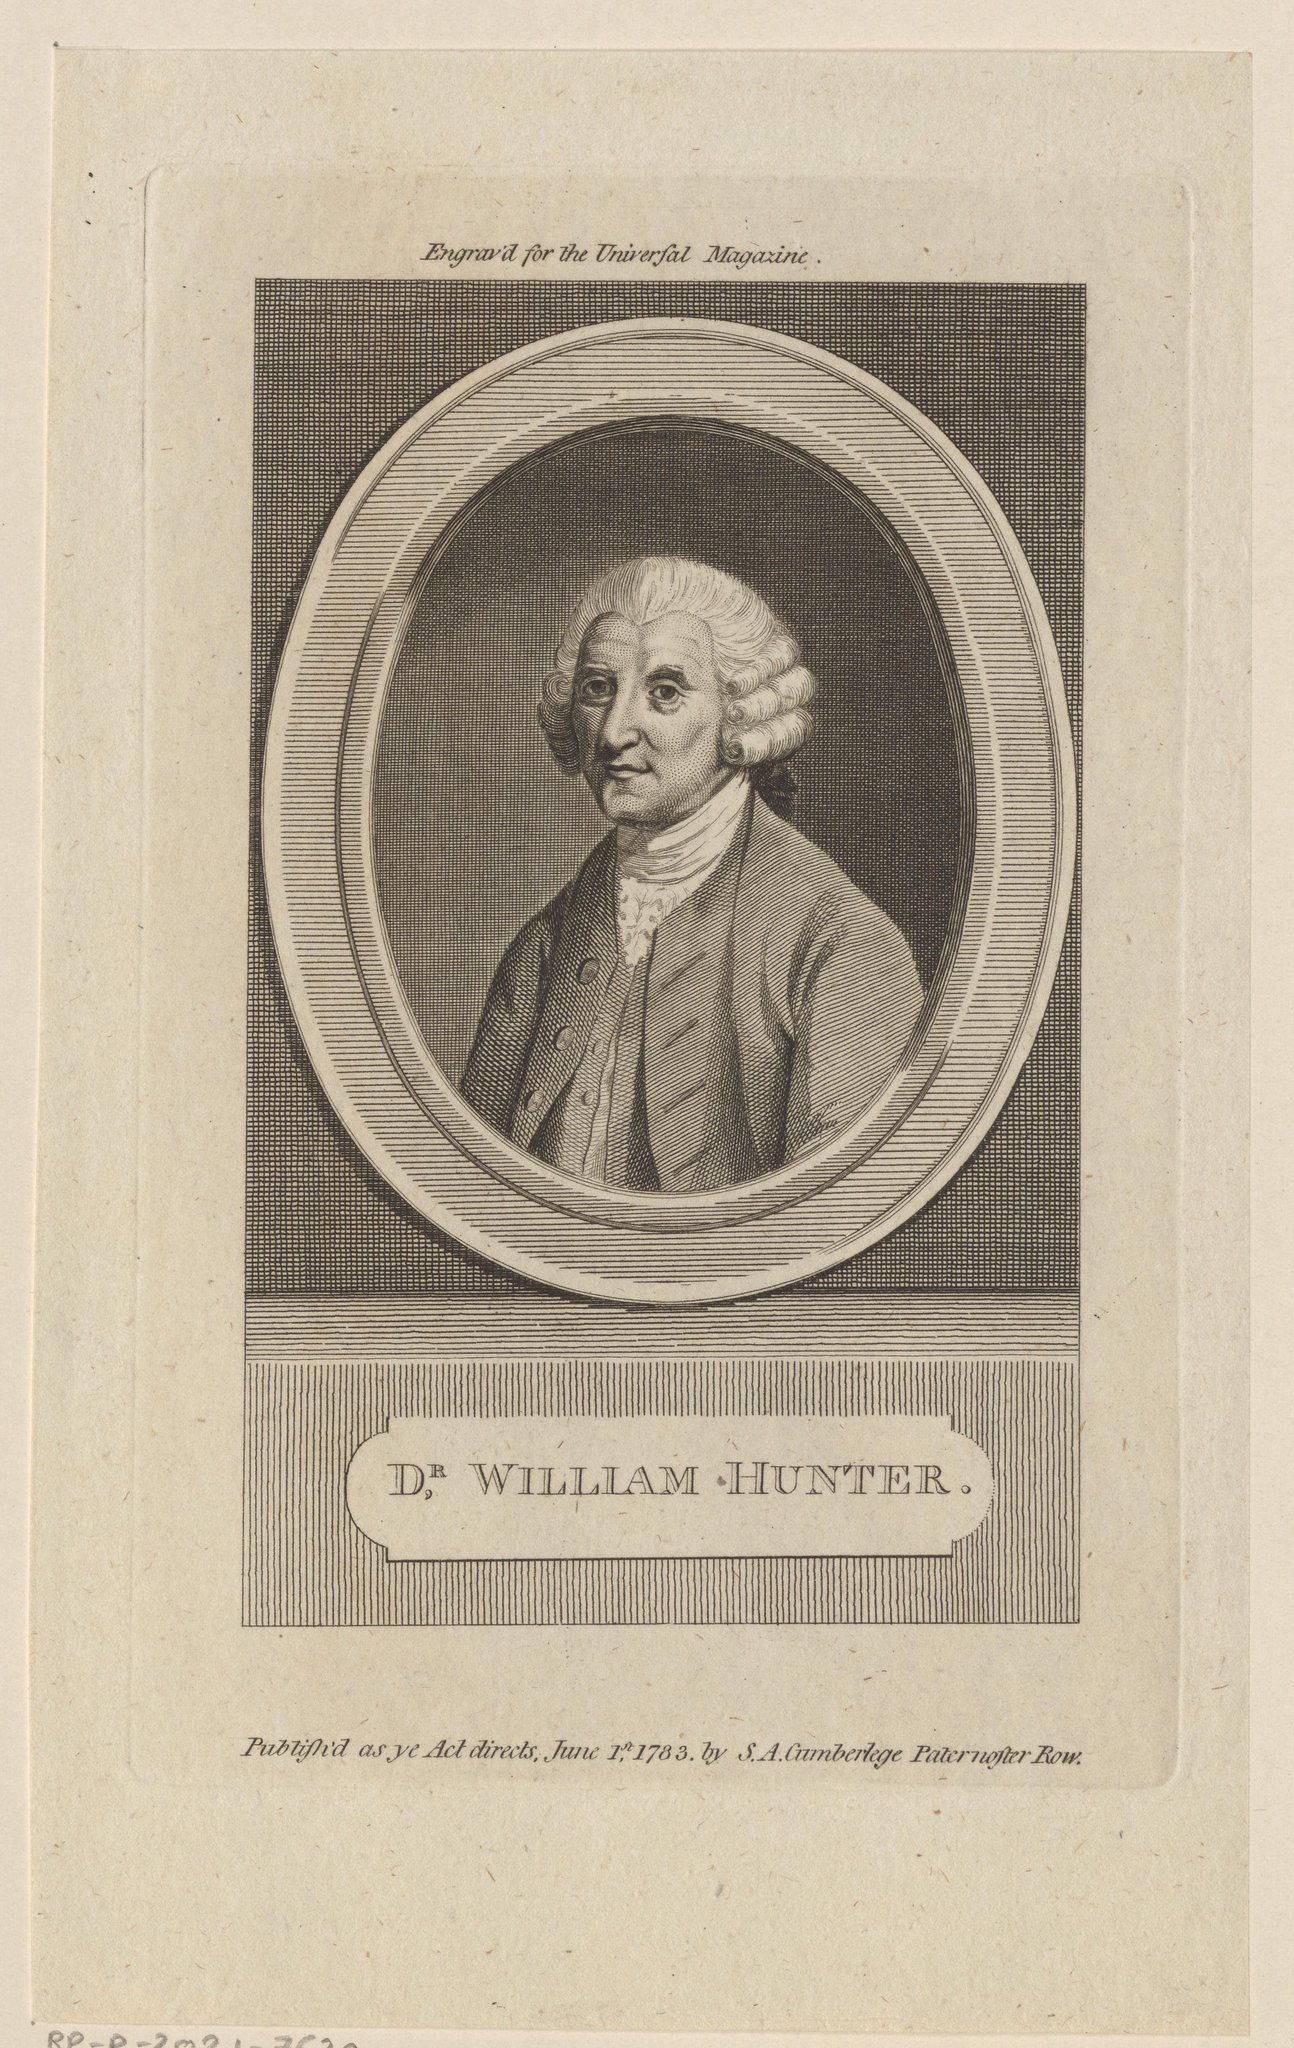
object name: print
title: Portret van William Hunter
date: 1783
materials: paper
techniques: engraving, etching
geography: london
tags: historical persons, physician, doctor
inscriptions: date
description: Prent uit: The Universal Magazine of Knowledge and Pleasure, 1 juni 1783.